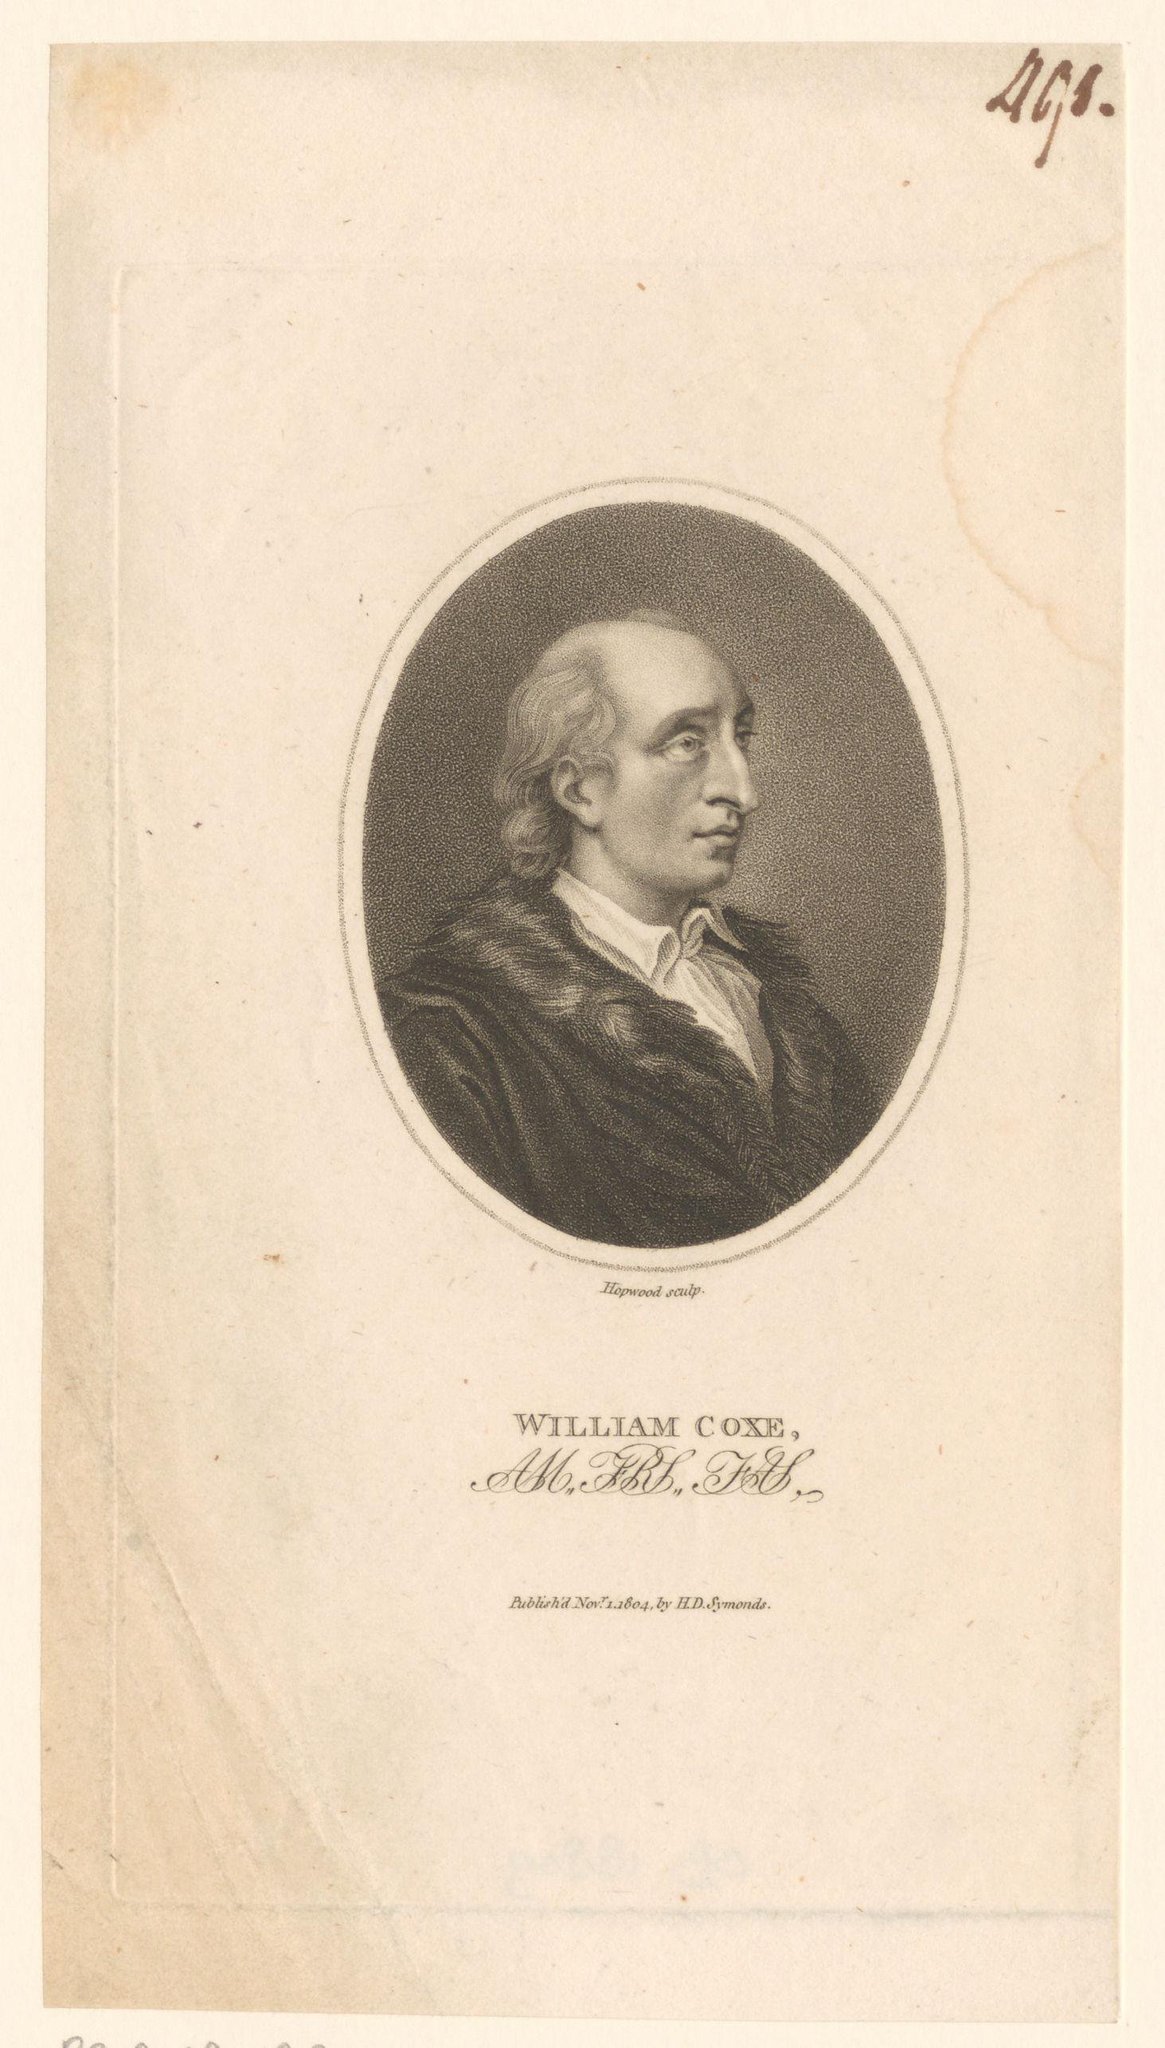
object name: print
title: Portret van William Coxe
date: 1804-1811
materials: paper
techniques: etching, engraving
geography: london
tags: historical persons, portrait of a writer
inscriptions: inscription: ‘491’, collector's mark: Lugt 2228